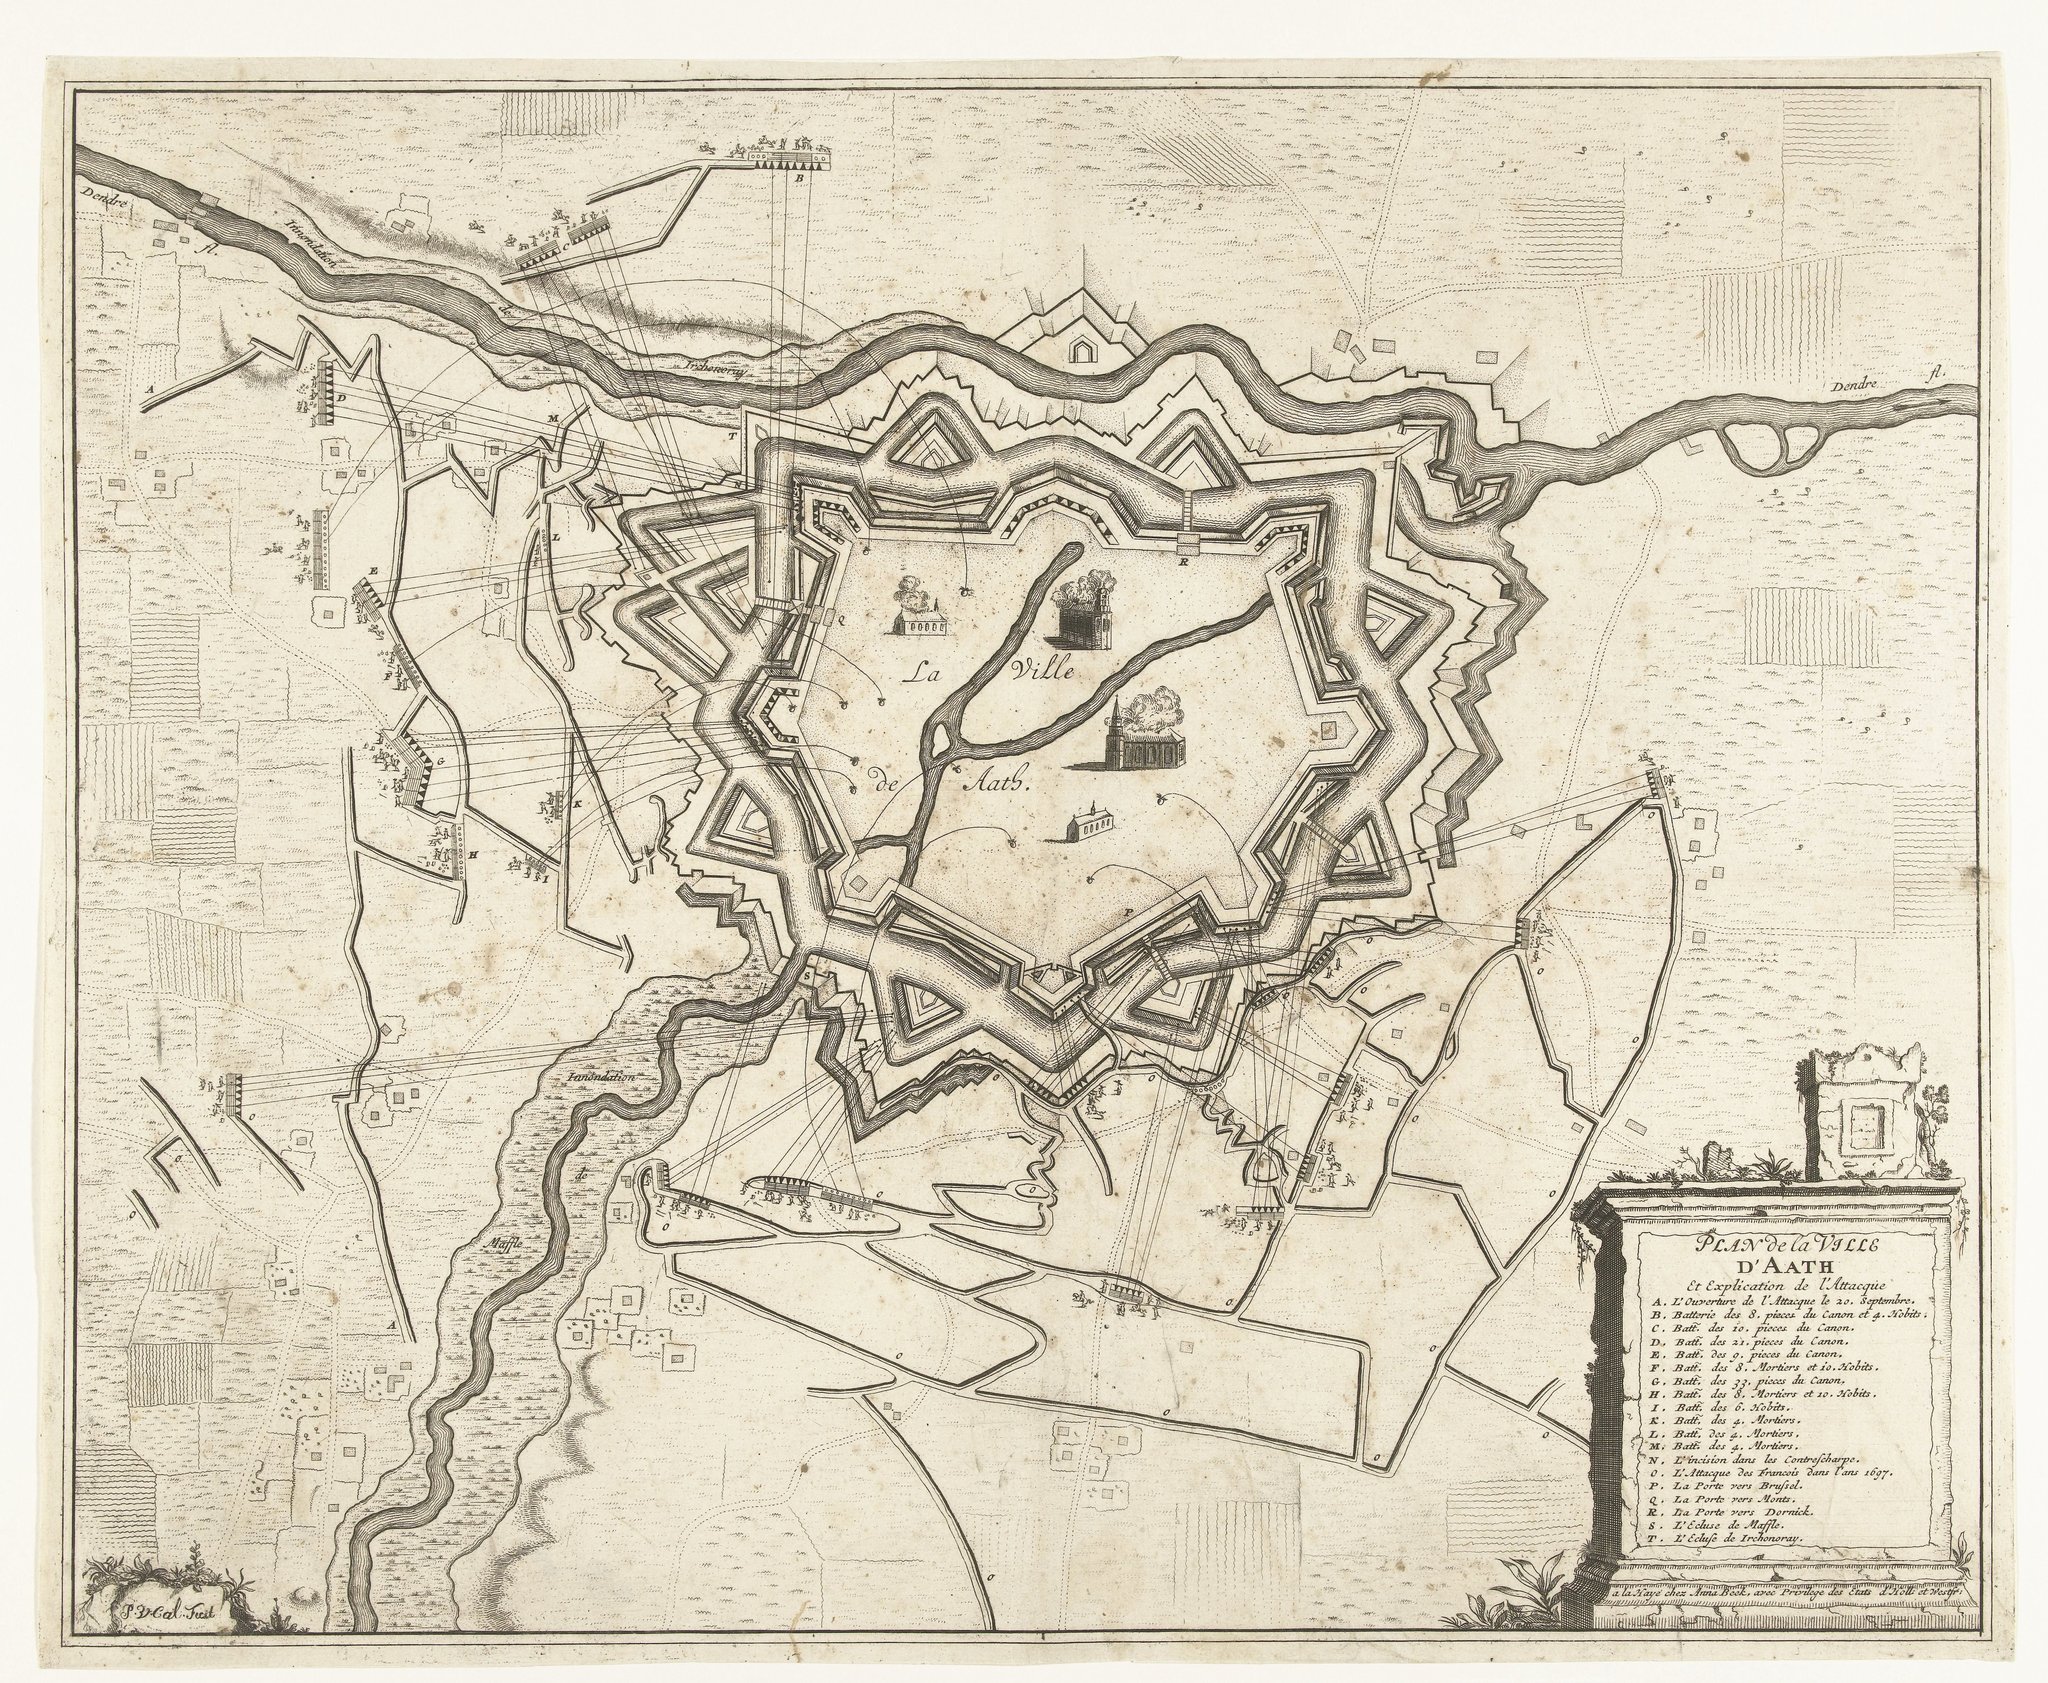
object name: print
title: Plan de la Ville de d'Aath Et Explication de l'Attacque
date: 1706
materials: paper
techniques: etching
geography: the hague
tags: siege, position war, maps of cities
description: In een latere staat zonder het adres gebruikt als illustratie in het tweede deel van : [Jean] du Mont, Oorlogskundige beschryving van de veldslagen en belegeringen, der drie ... wydvermaarde krygsoversten... den Prins Eugenius van Savoye, den ... Hertog van Marlborough, en den Prins van Oranje en Nassau-Vriesland, in de editie van 1729; zie FMH 3032/II/29.